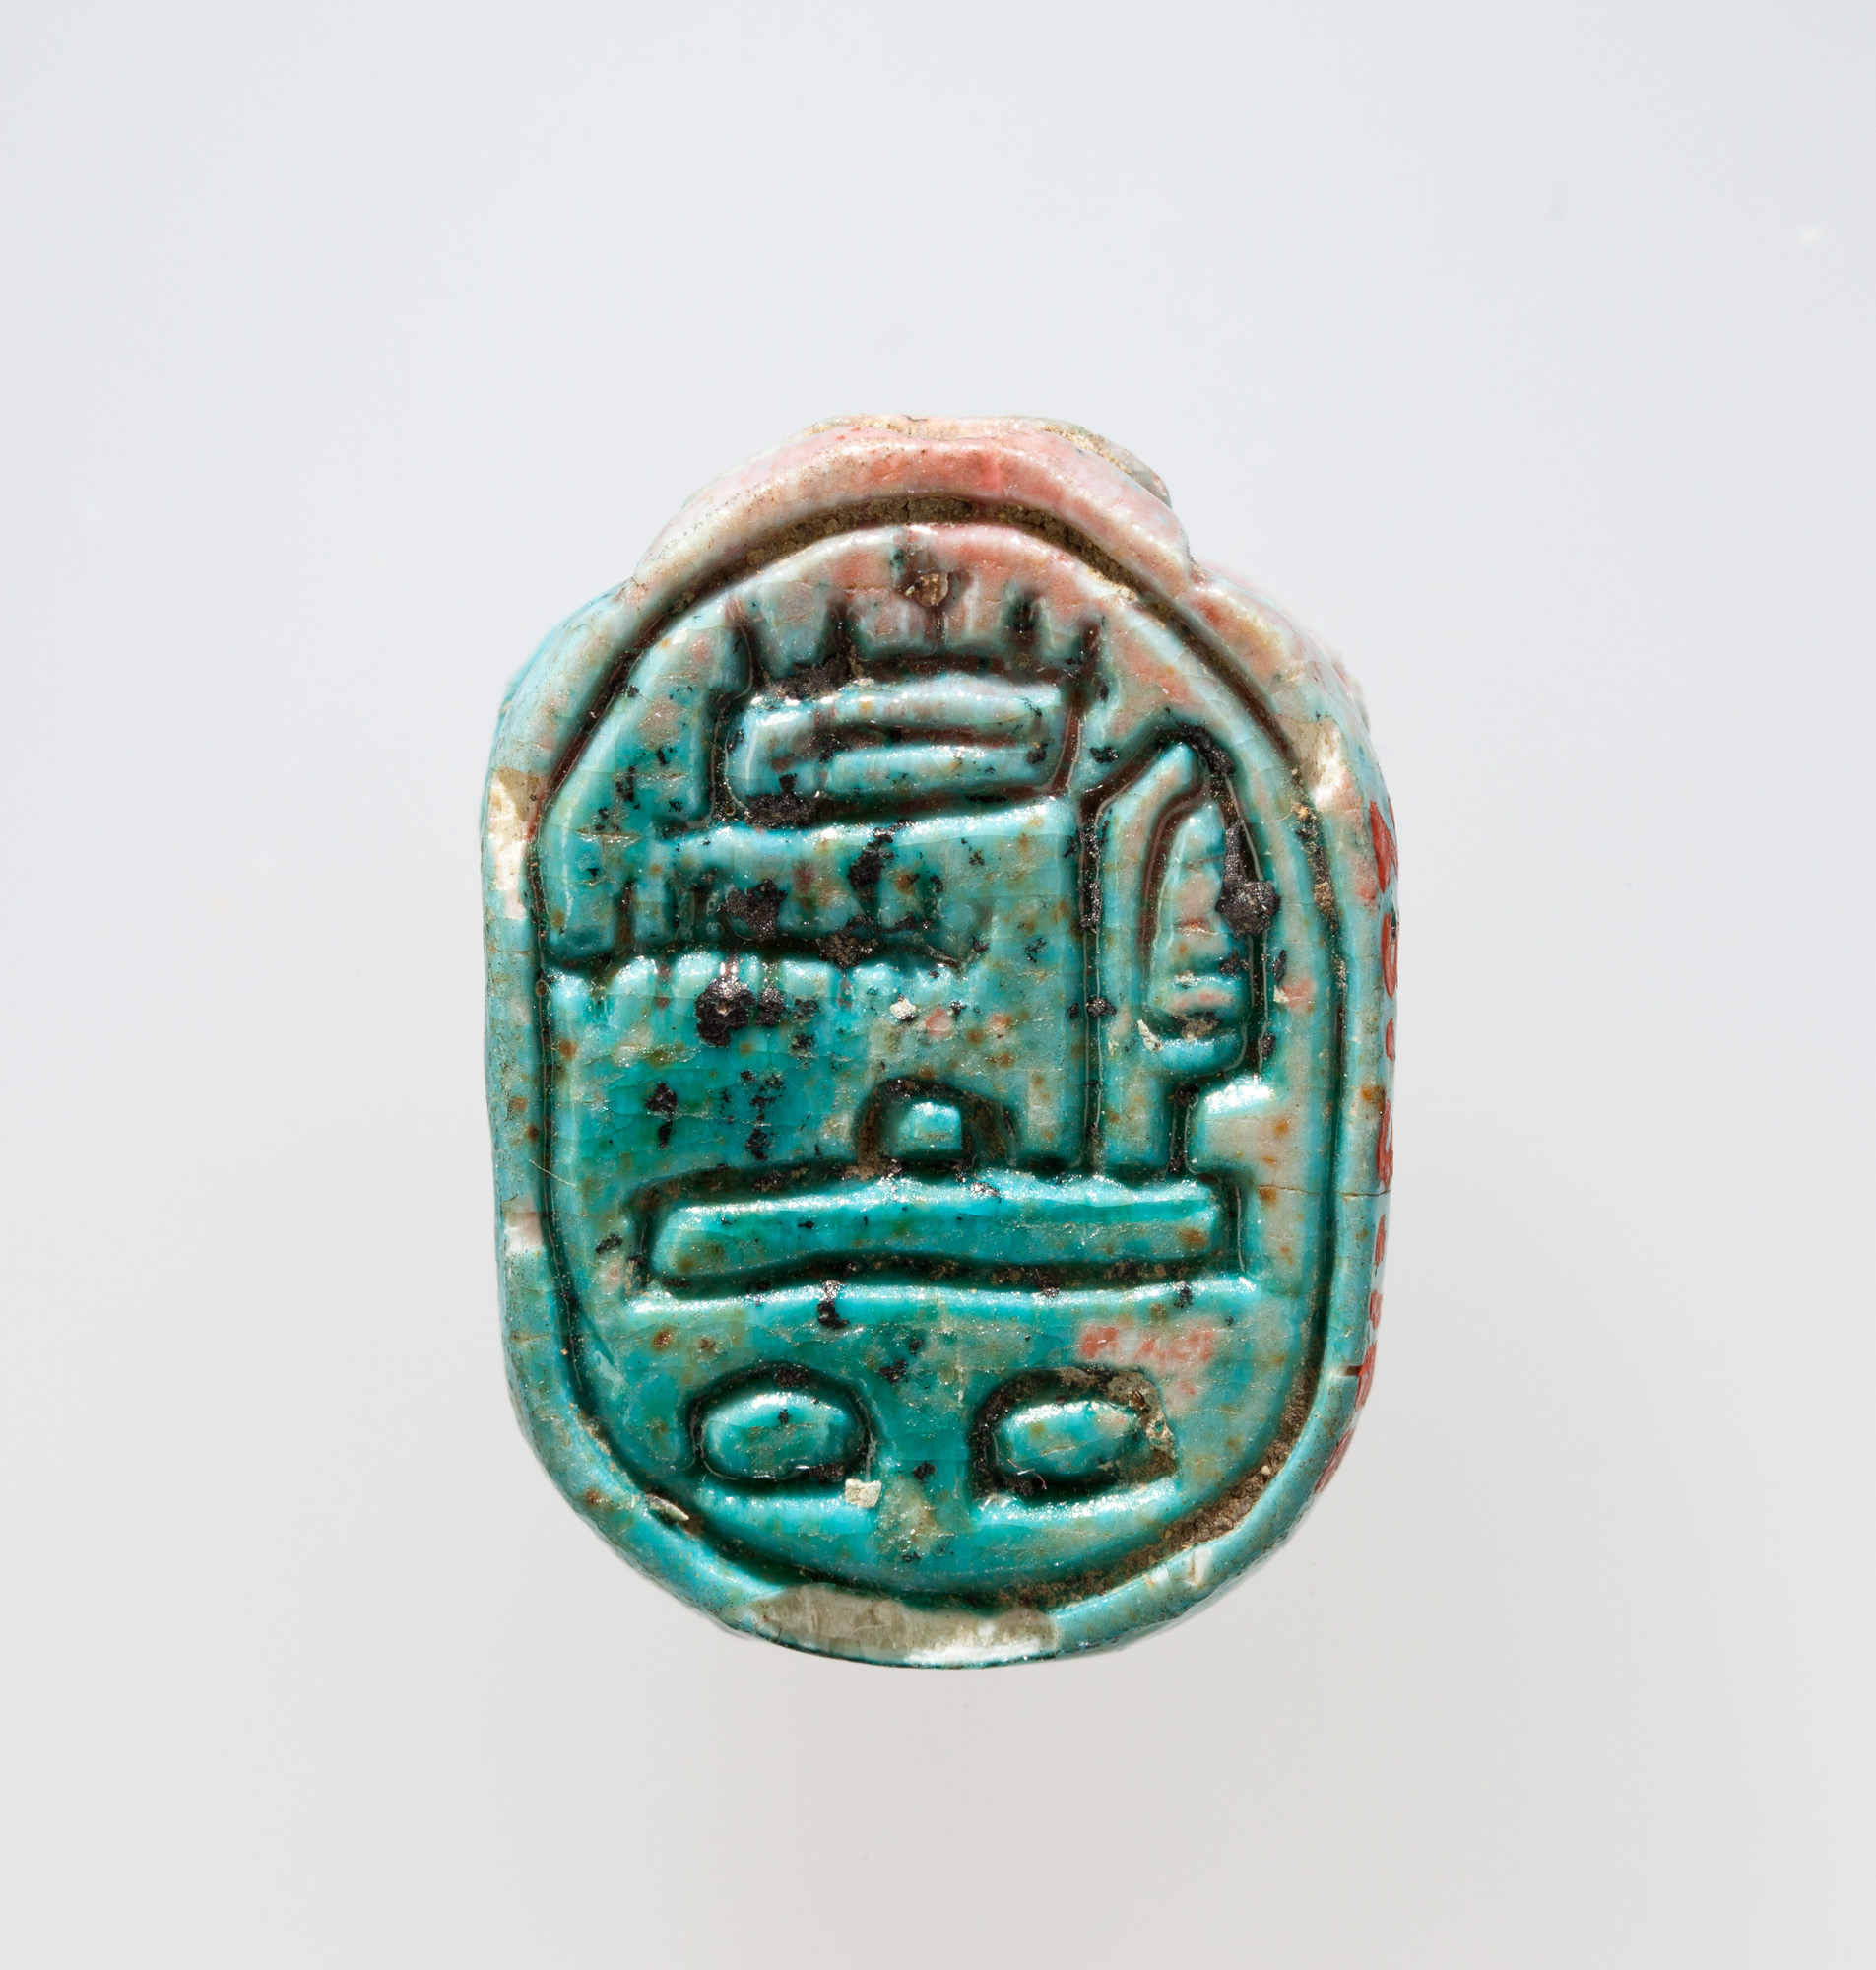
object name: seal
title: Scarab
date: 1479-1458 BCE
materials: faience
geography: egypt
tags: faces,hieroglyphs,scarabs